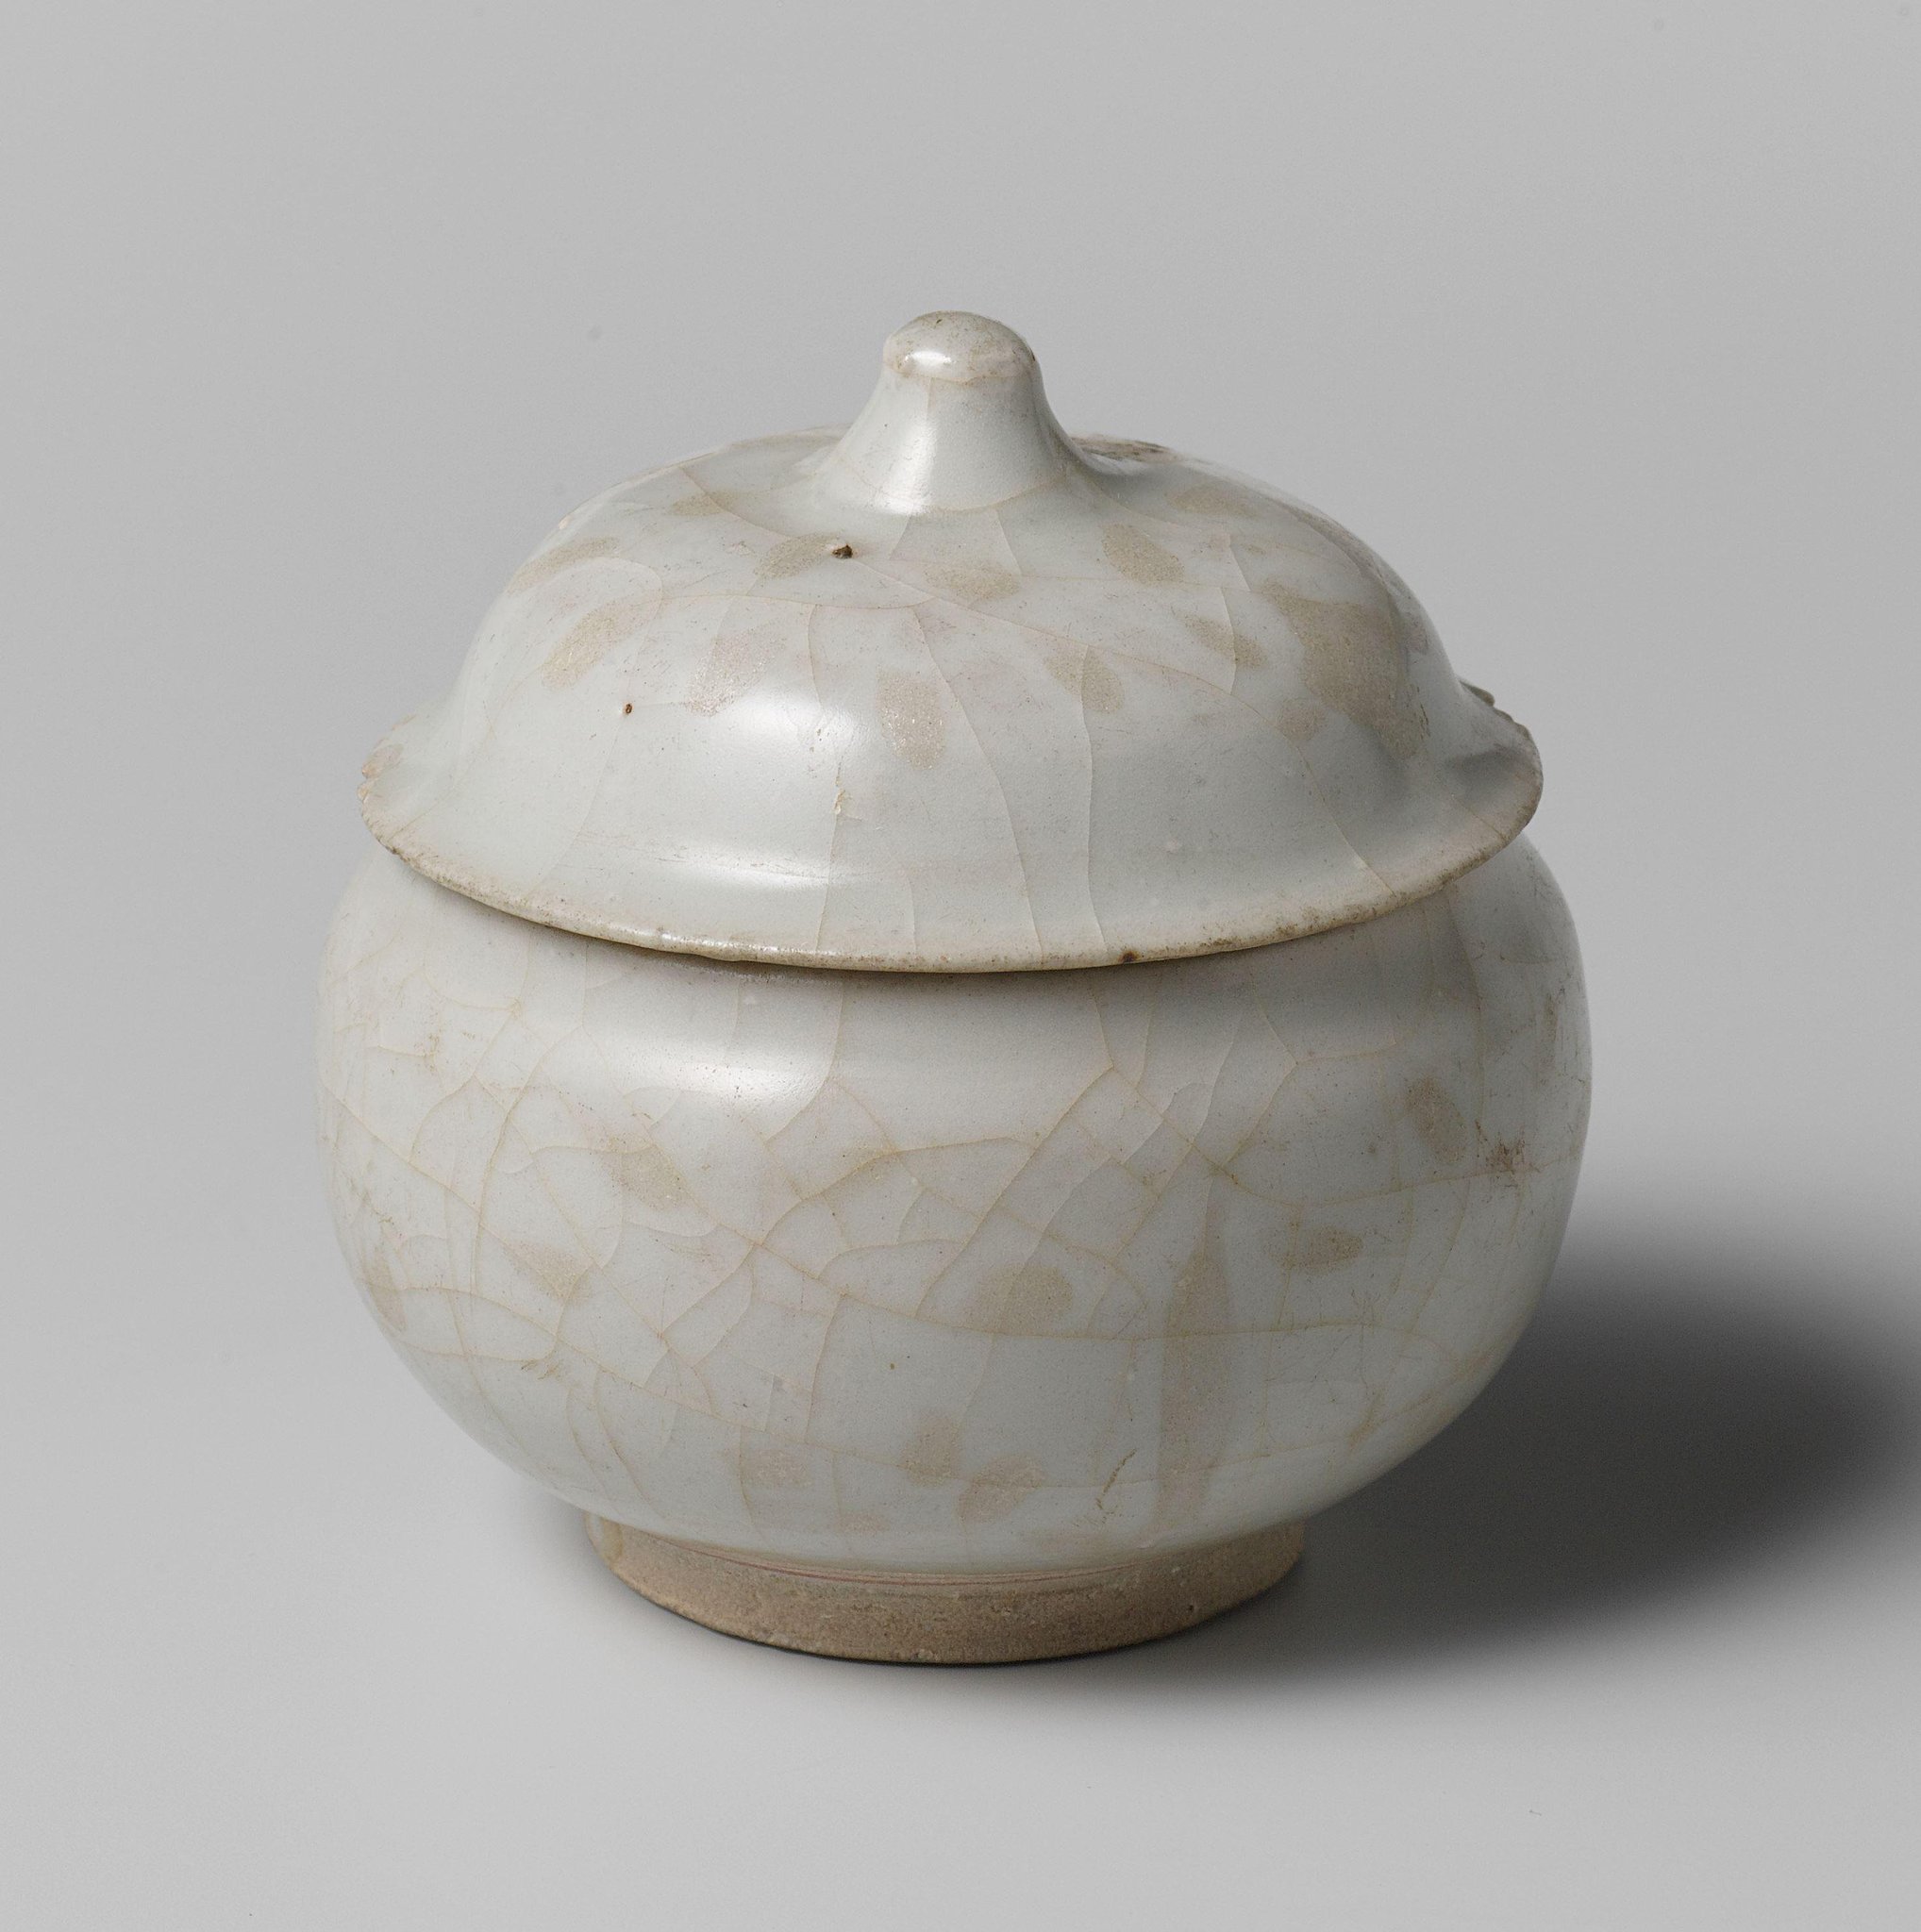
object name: covered jar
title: Covered jar with a bluish white glaze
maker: Anonymous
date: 1279-1368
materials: glaze, stoneware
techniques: firing, turning, vitrification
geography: china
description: Dekselpot van steengoed met een bolvormige wand, bedekt met een gecraqueleerd, transparant glazuur met een blauwwitte tint. Op het glazuur onregelmatige vlekjes. Voetring ongeglazuurd. Qingbai.